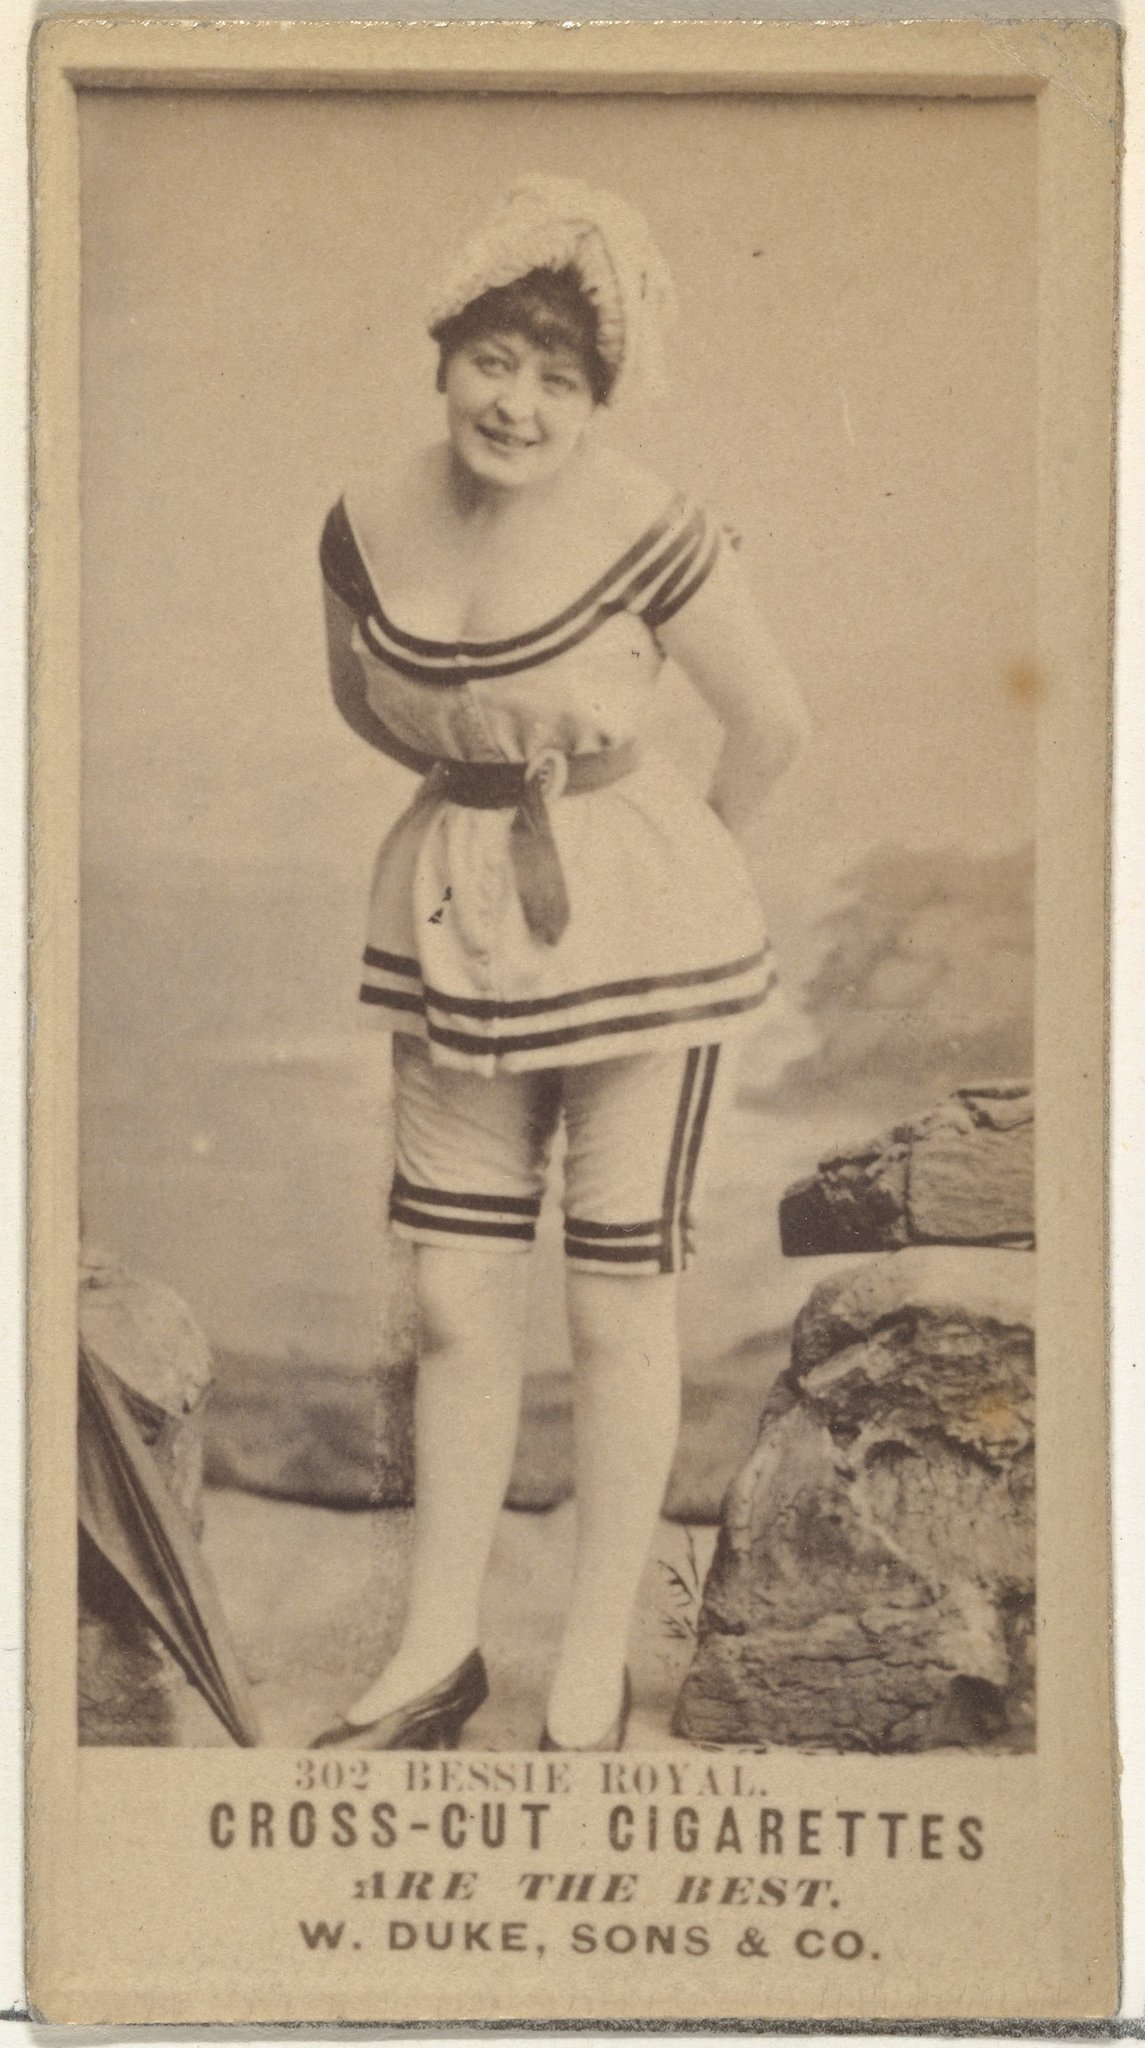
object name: photograph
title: Card Number 302, Bessie Royal, from the Actors and Actresses series (N145-3) issued by Duke Sons & Co. to promote Cross Cut Cigarettes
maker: w. duke, sons & co.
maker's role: publisher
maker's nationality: american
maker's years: 1870-1920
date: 1880-1889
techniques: albumen silver print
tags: portraits,women,actresses